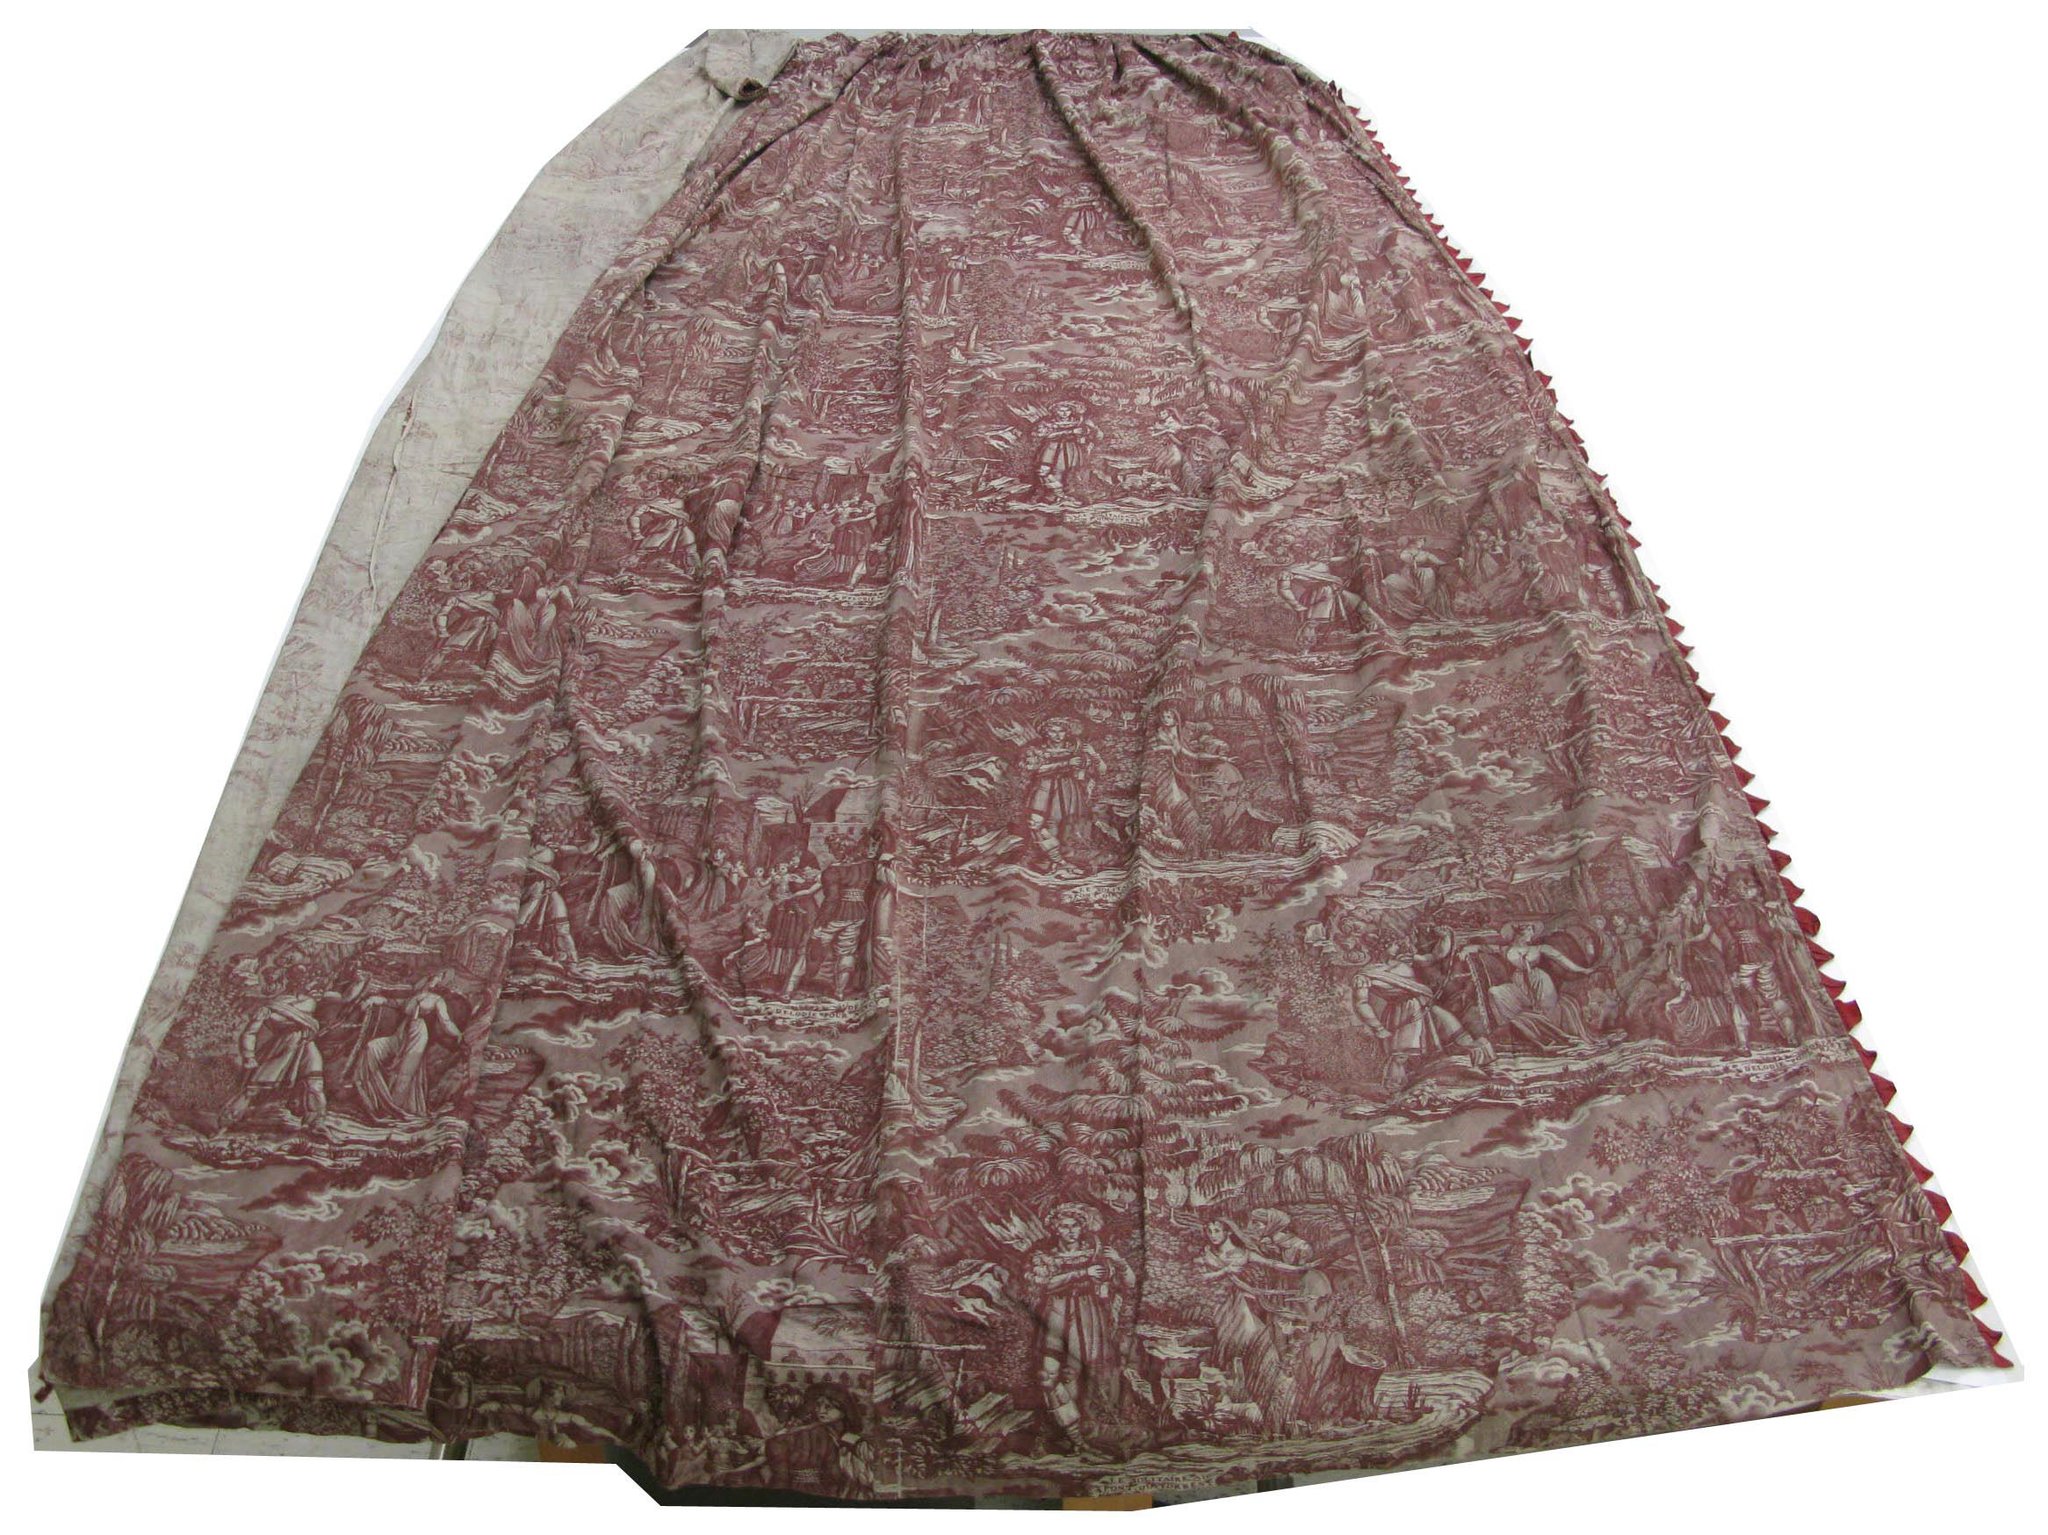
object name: curtain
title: Elodie (?)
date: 1801-1825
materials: cotton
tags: infants,men,women,horses